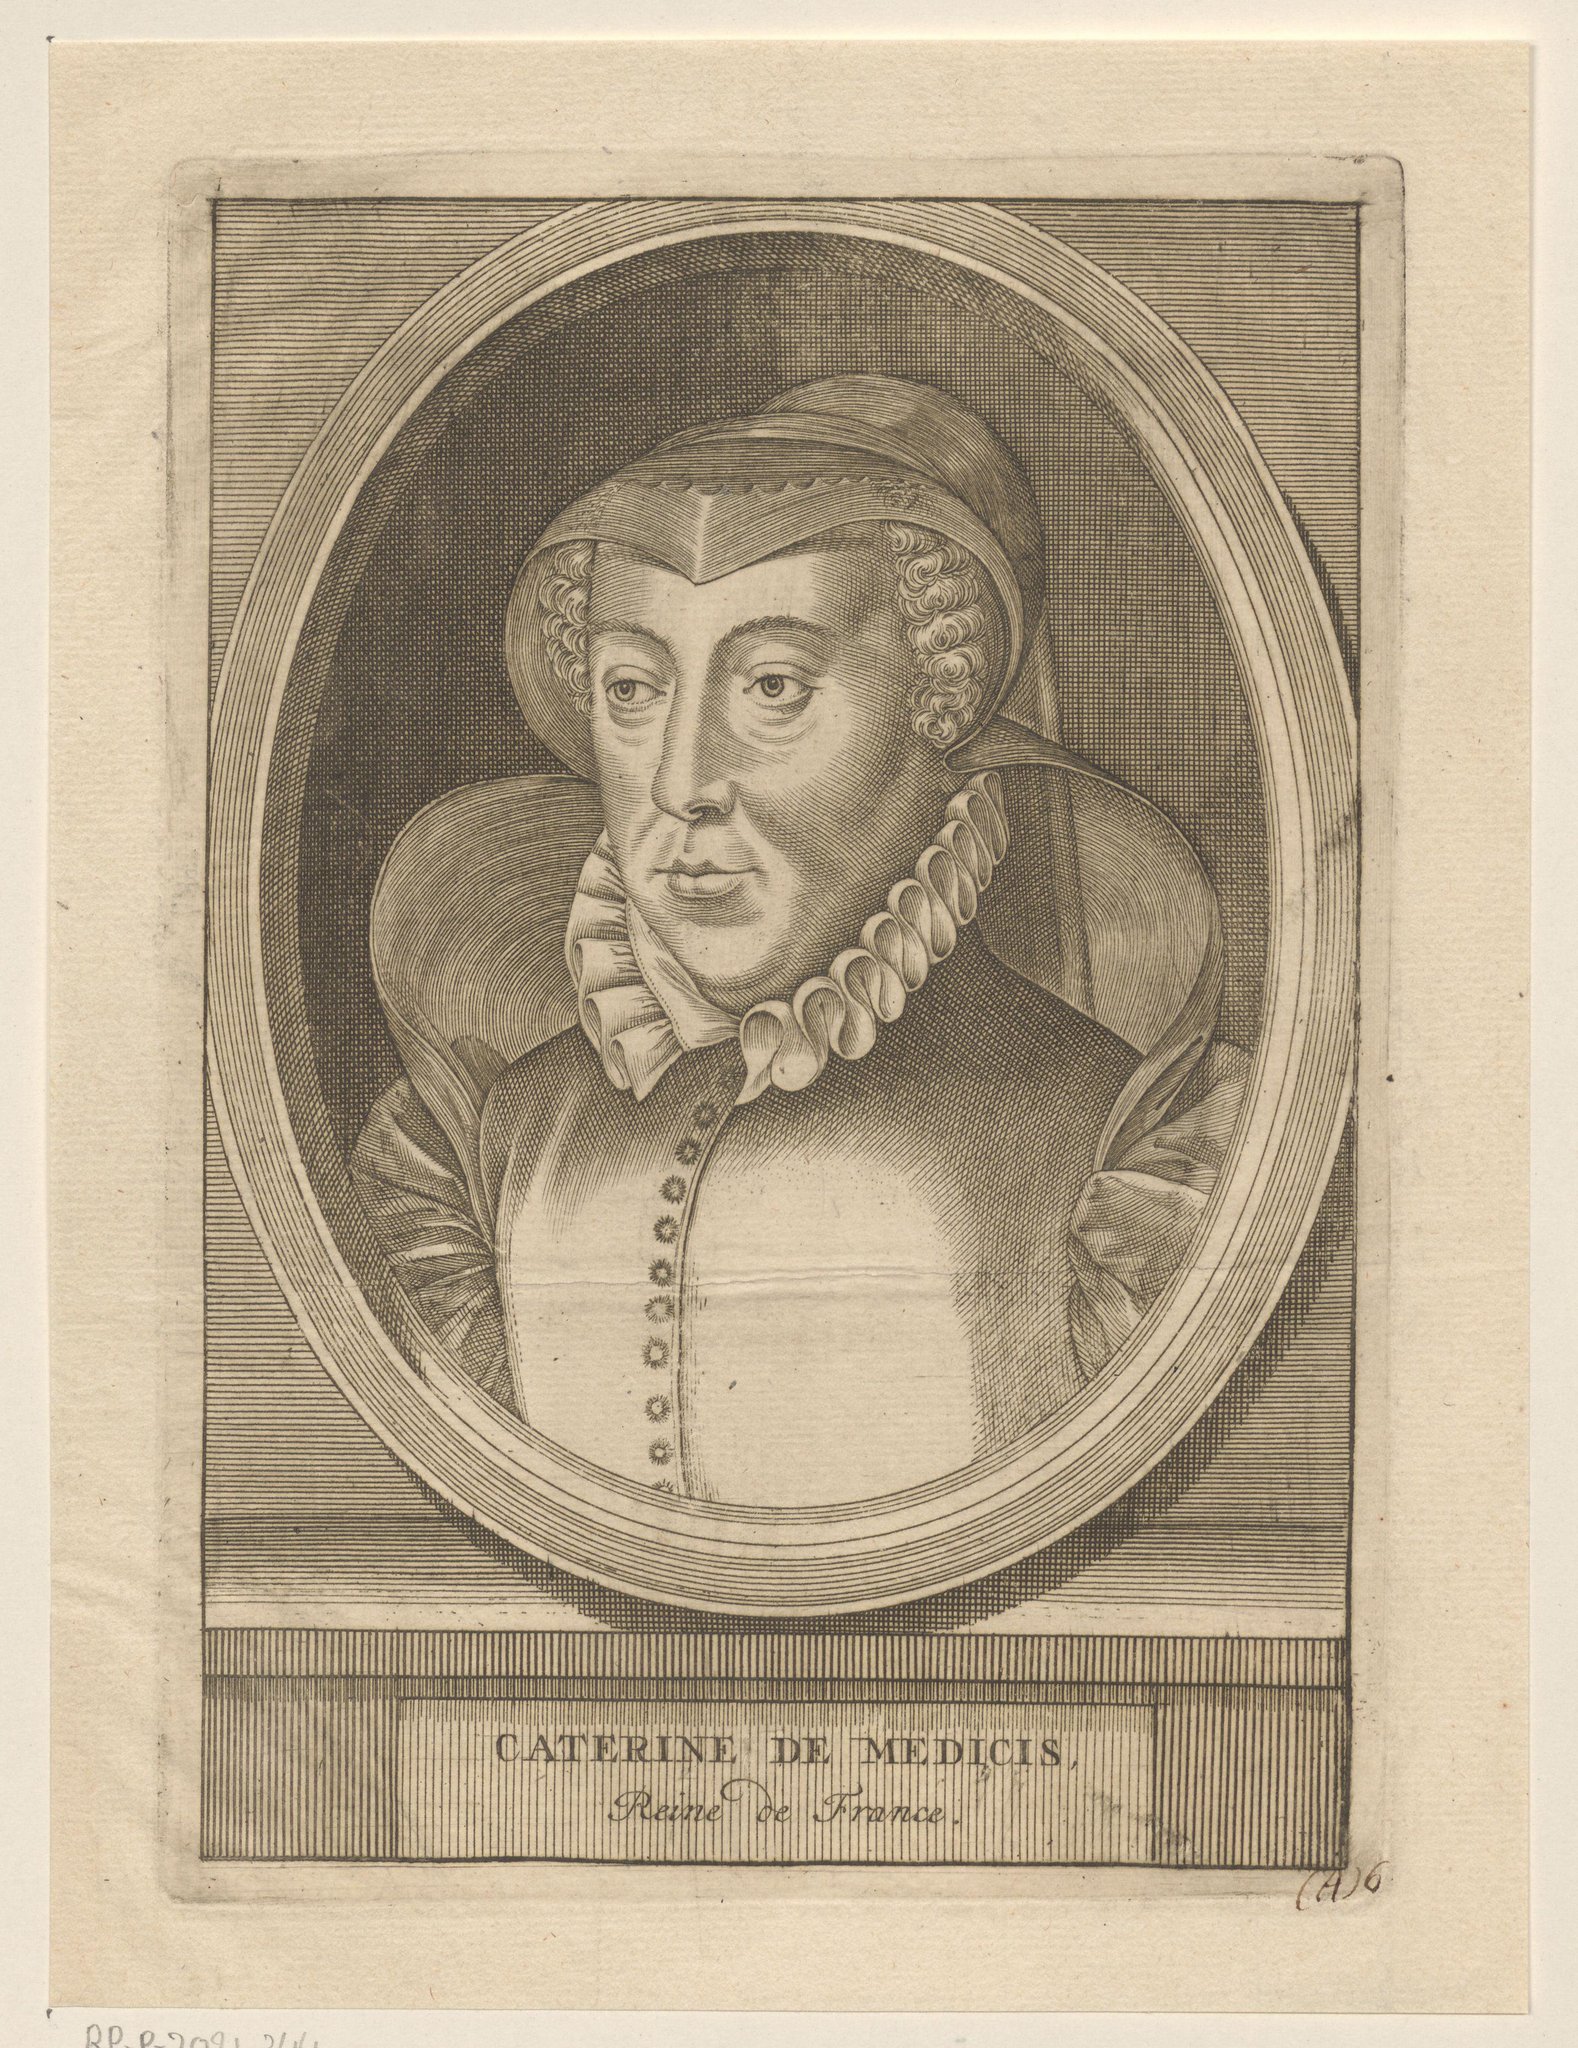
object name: print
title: Portret van Catharina de'Medici, koningin van Frankrijk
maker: Anonymous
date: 1650-1749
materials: paper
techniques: engraving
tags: historical persons - bb - woman, queen